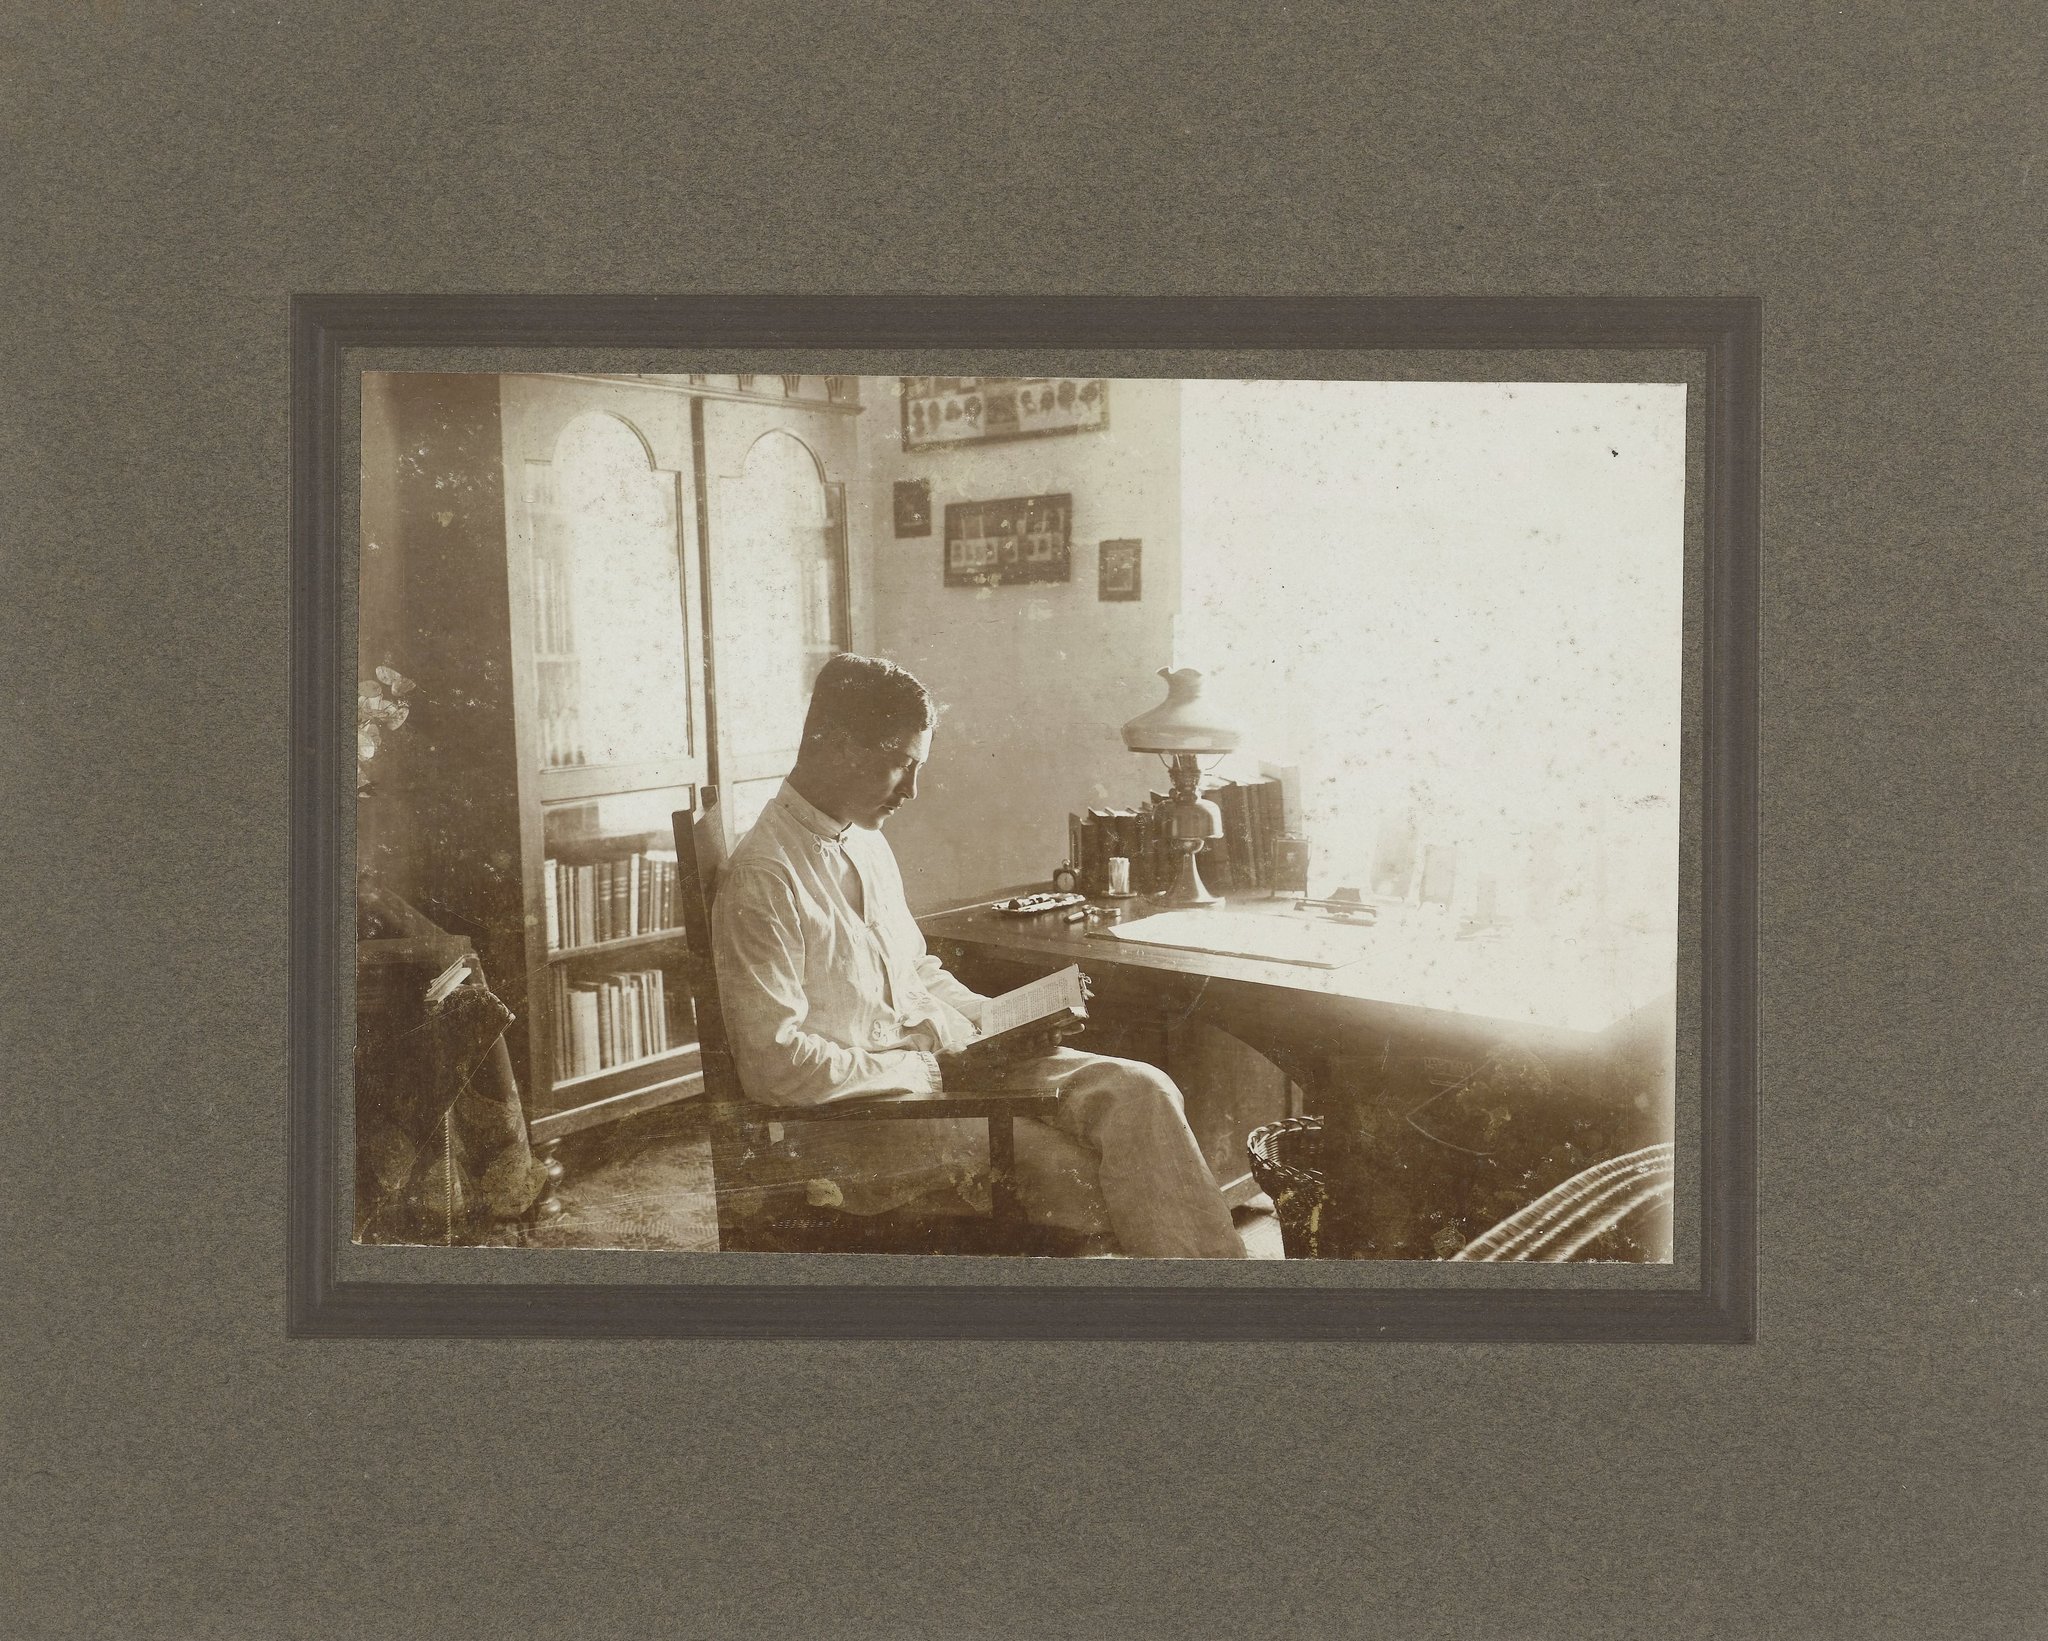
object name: photograph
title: Portret van een onbekende lezende man in een stoel, Tanjung Pinang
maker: Anonymous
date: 1912-1913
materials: paper, cardboard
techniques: collodion silver print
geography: tanjung pinang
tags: writing-table, writing-desk, reading, anonymous historical person portrayed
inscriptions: inscription: ‘Ma/ Tandjong-Pinang, Dec. 1913’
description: Zie gerelateerde objecten voor andere foto's van dezelfde man.